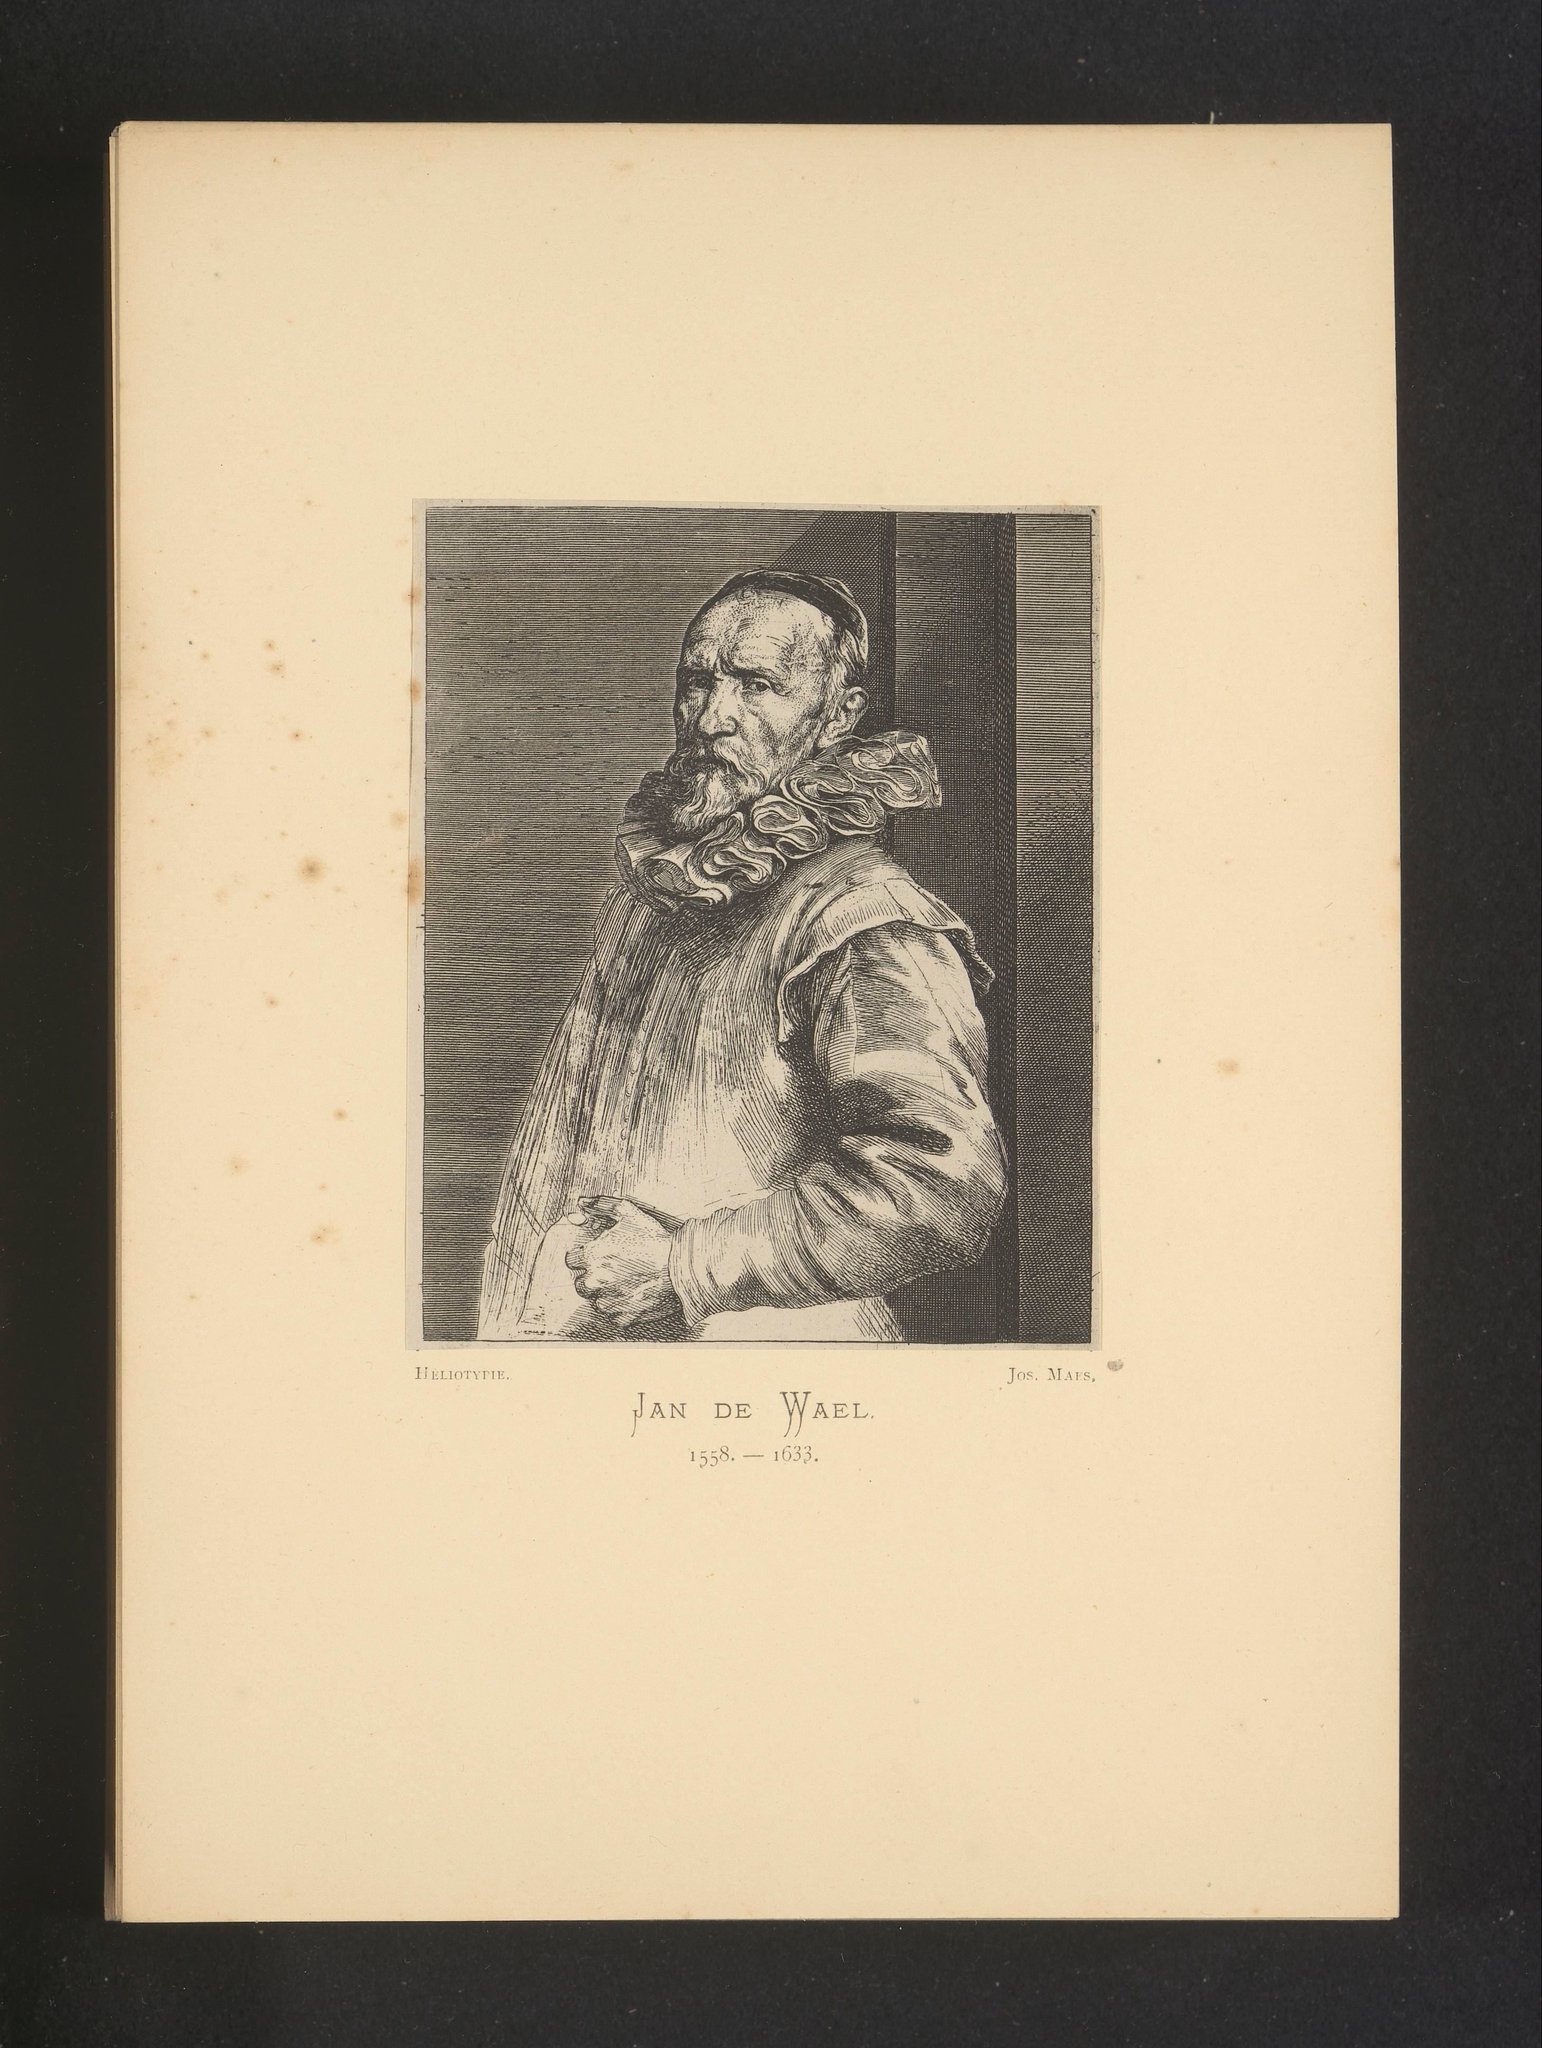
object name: reproduction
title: Reproductie van een gravure van een portret van Hans de Wael door Anthony van Dyck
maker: joseph maes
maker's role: fotograaf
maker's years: 1838-1908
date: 1872-1877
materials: cardboard, paper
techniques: photograph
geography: antwerp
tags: antwerp, painter, hans de wael, historical persons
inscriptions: inscription: ‘1558. - 1633.’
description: Deze prent maakt deel uit van een omslag met 150 prenten en een katern met een lijst van afbeeldingen.